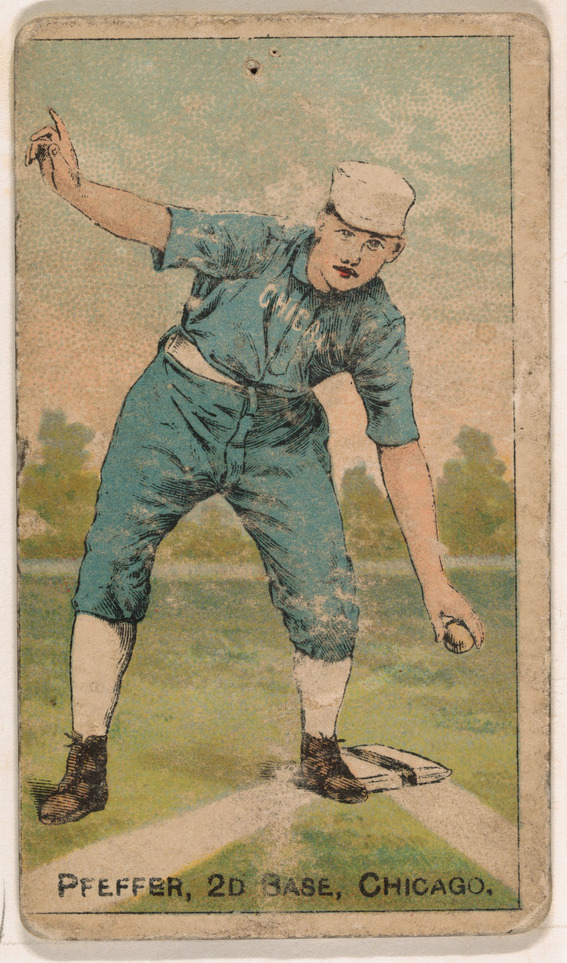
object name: baseball card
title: Pfeffer, 2nd Base, Chicago, from the Gold Coin series (N284) for Gold Coin Chewing Tobacco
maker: d. buchner & co., new york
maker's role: publisher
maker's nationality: american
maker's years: 1850-1900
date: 1887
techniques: color lithograph, drawing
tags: men,baseball,athletes